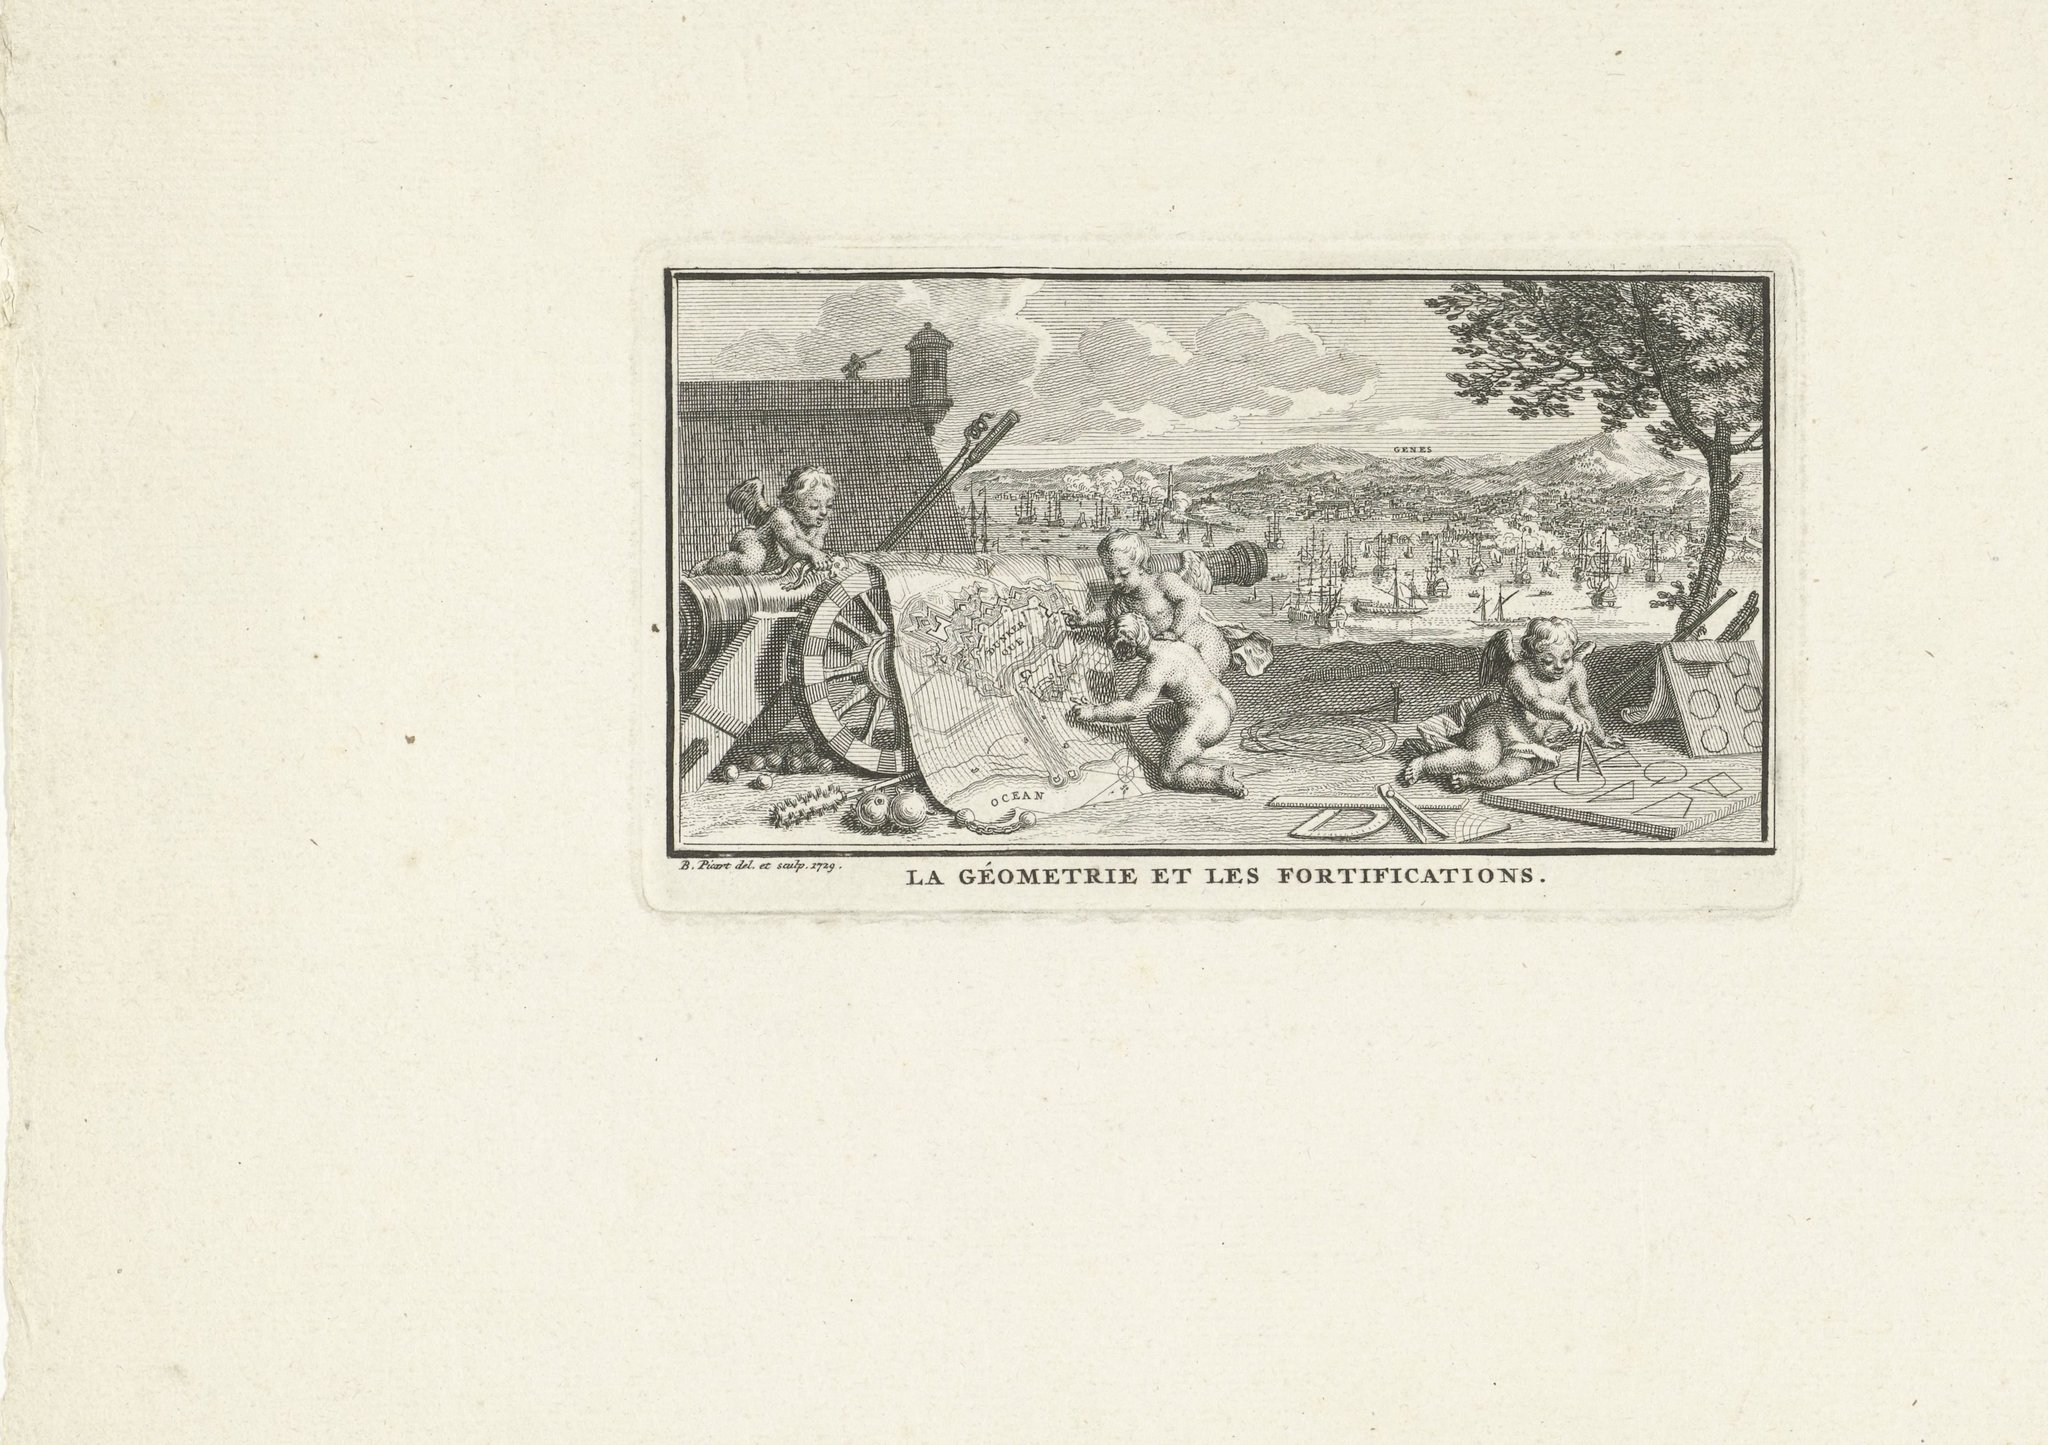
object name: print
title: Allegorie op geometrie en bouwkunde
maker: bernard picart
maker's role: draughtsman, print maker, publisher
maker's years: 1673-1733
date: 1729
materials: paper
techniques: engraving, etching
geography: amsterdam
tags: planimetry, geometry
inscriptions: collector's mark: Lugt 2228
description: Putti bestuderen een landkaart bij een kanon. Een andere putto tekent met een passer diverse geometrische figuren. Op de achtergrond een gezicht op de Italiaanse havenstad Genua.